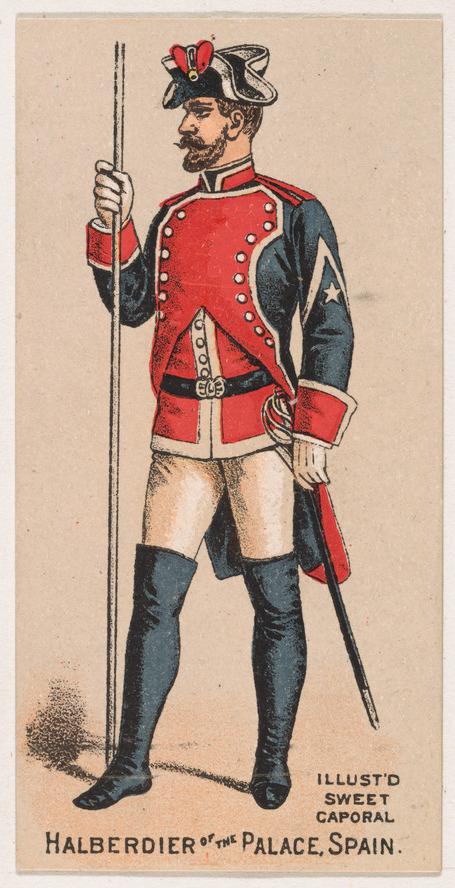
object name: print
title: Halberdier of the Palace, Spain, from the Military Series (N224) issued by Kinney Tobacco Company to promote Sweet Caporal Cigarettes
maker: kinney brothers tobacco company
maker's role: publisher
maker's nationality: american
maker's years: 1869-2011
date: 1888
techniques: color lithograph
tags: soldiers,men,profiles